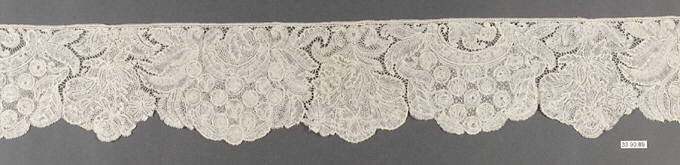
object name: edging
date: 1701-1733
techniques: lace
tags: flowers